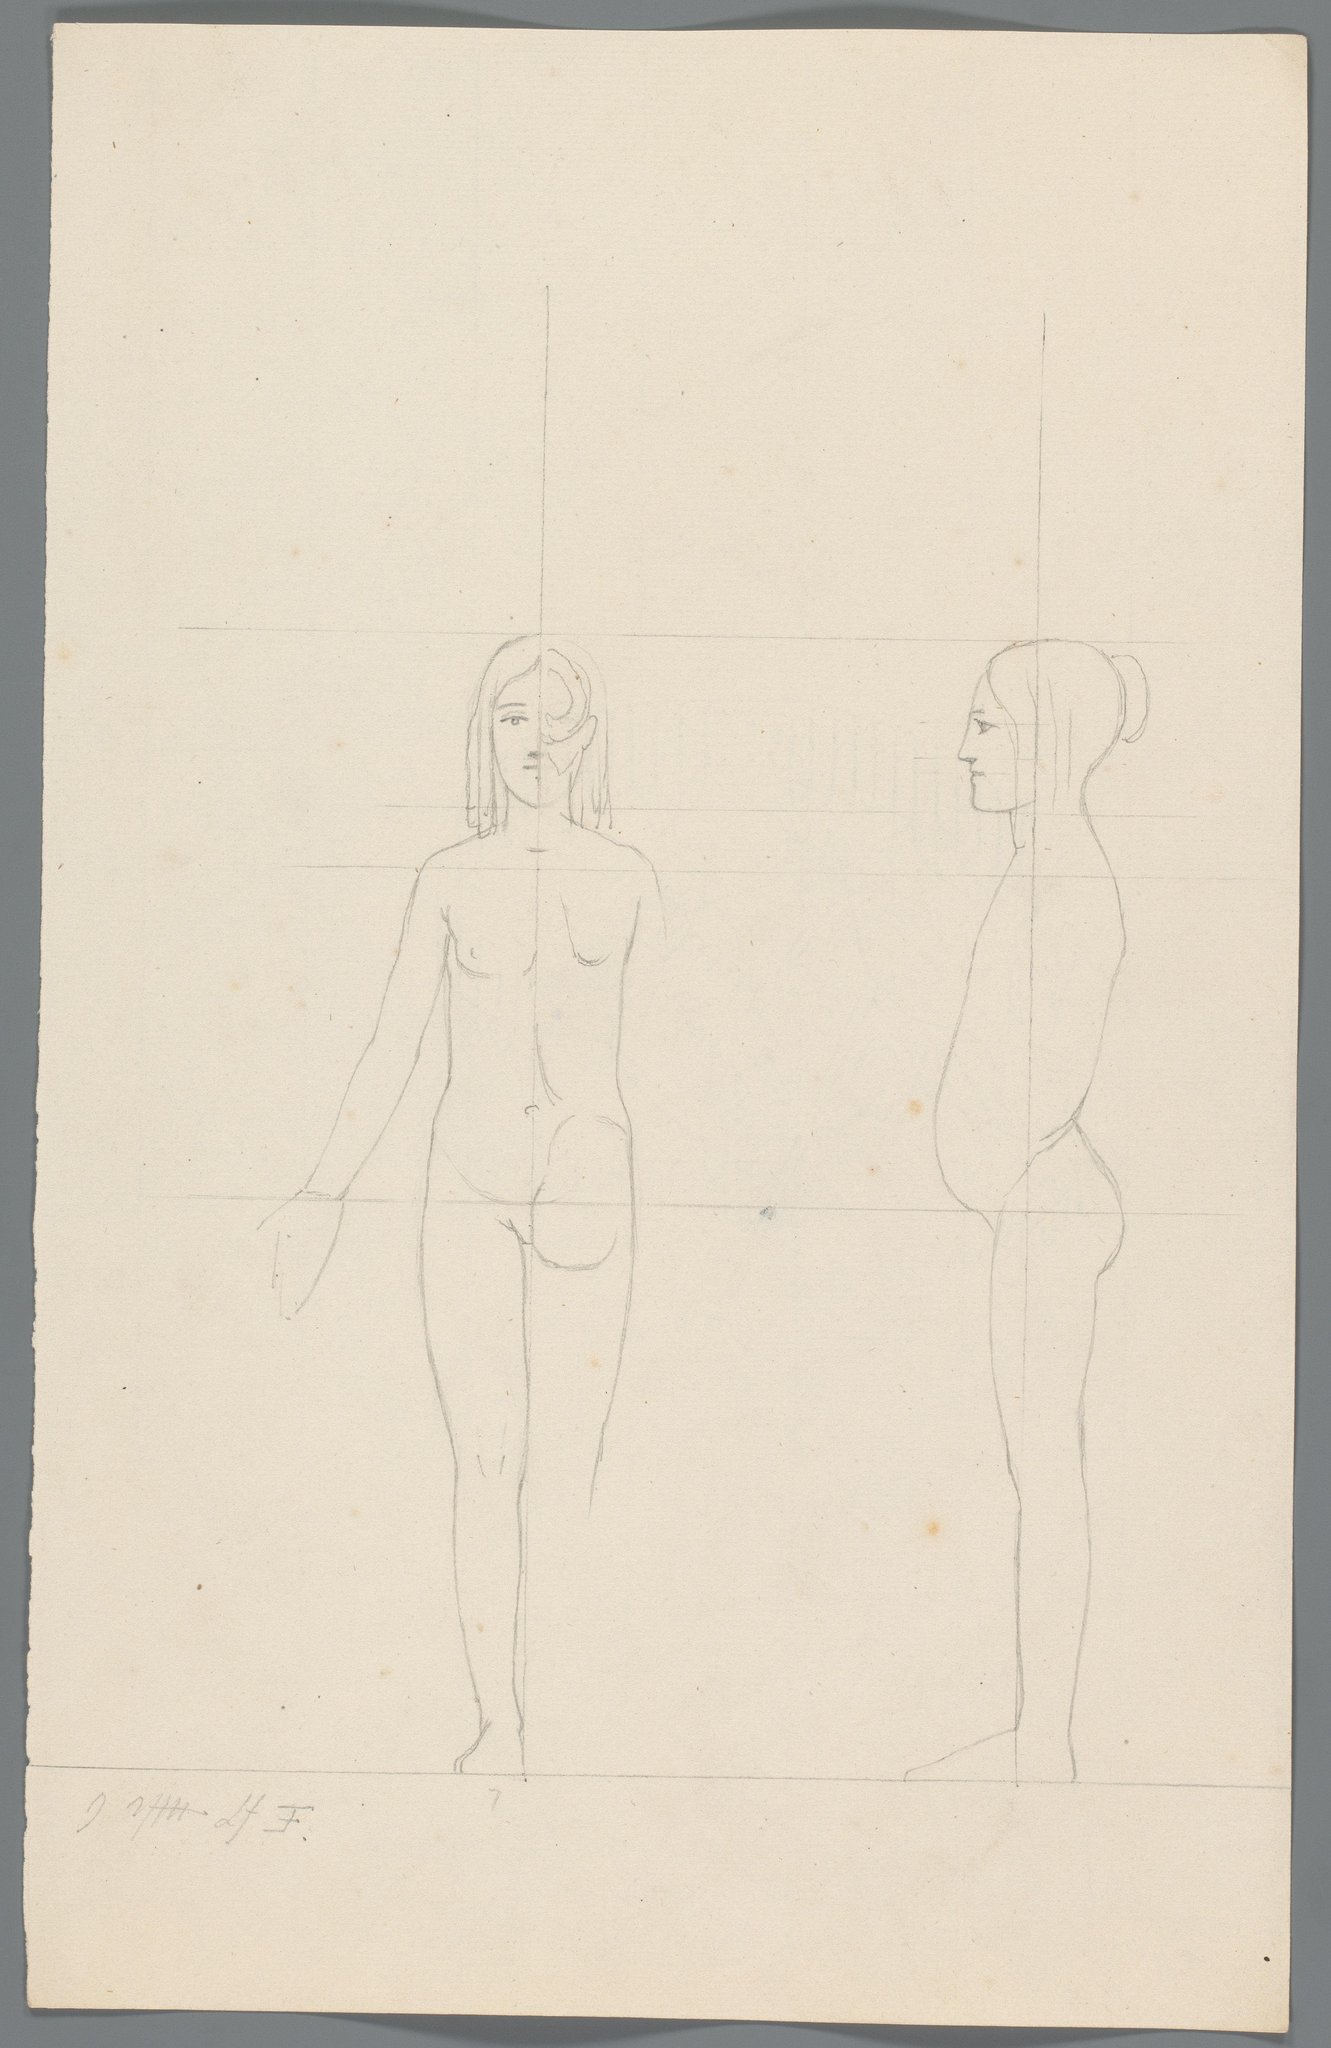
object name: drawing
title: Proportiestudie van een meisje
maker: jacobus everhardus josephus van den berg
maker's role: draughtsman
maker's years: 1802-1861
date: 1856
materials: paper, pencil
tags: standing figure (canon, proportions) - aa - female human figure, anatomy (non-medical) - aa - female human figure, child (at home) - aa - girl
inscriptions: inscription: ‘[...] lf EF.’